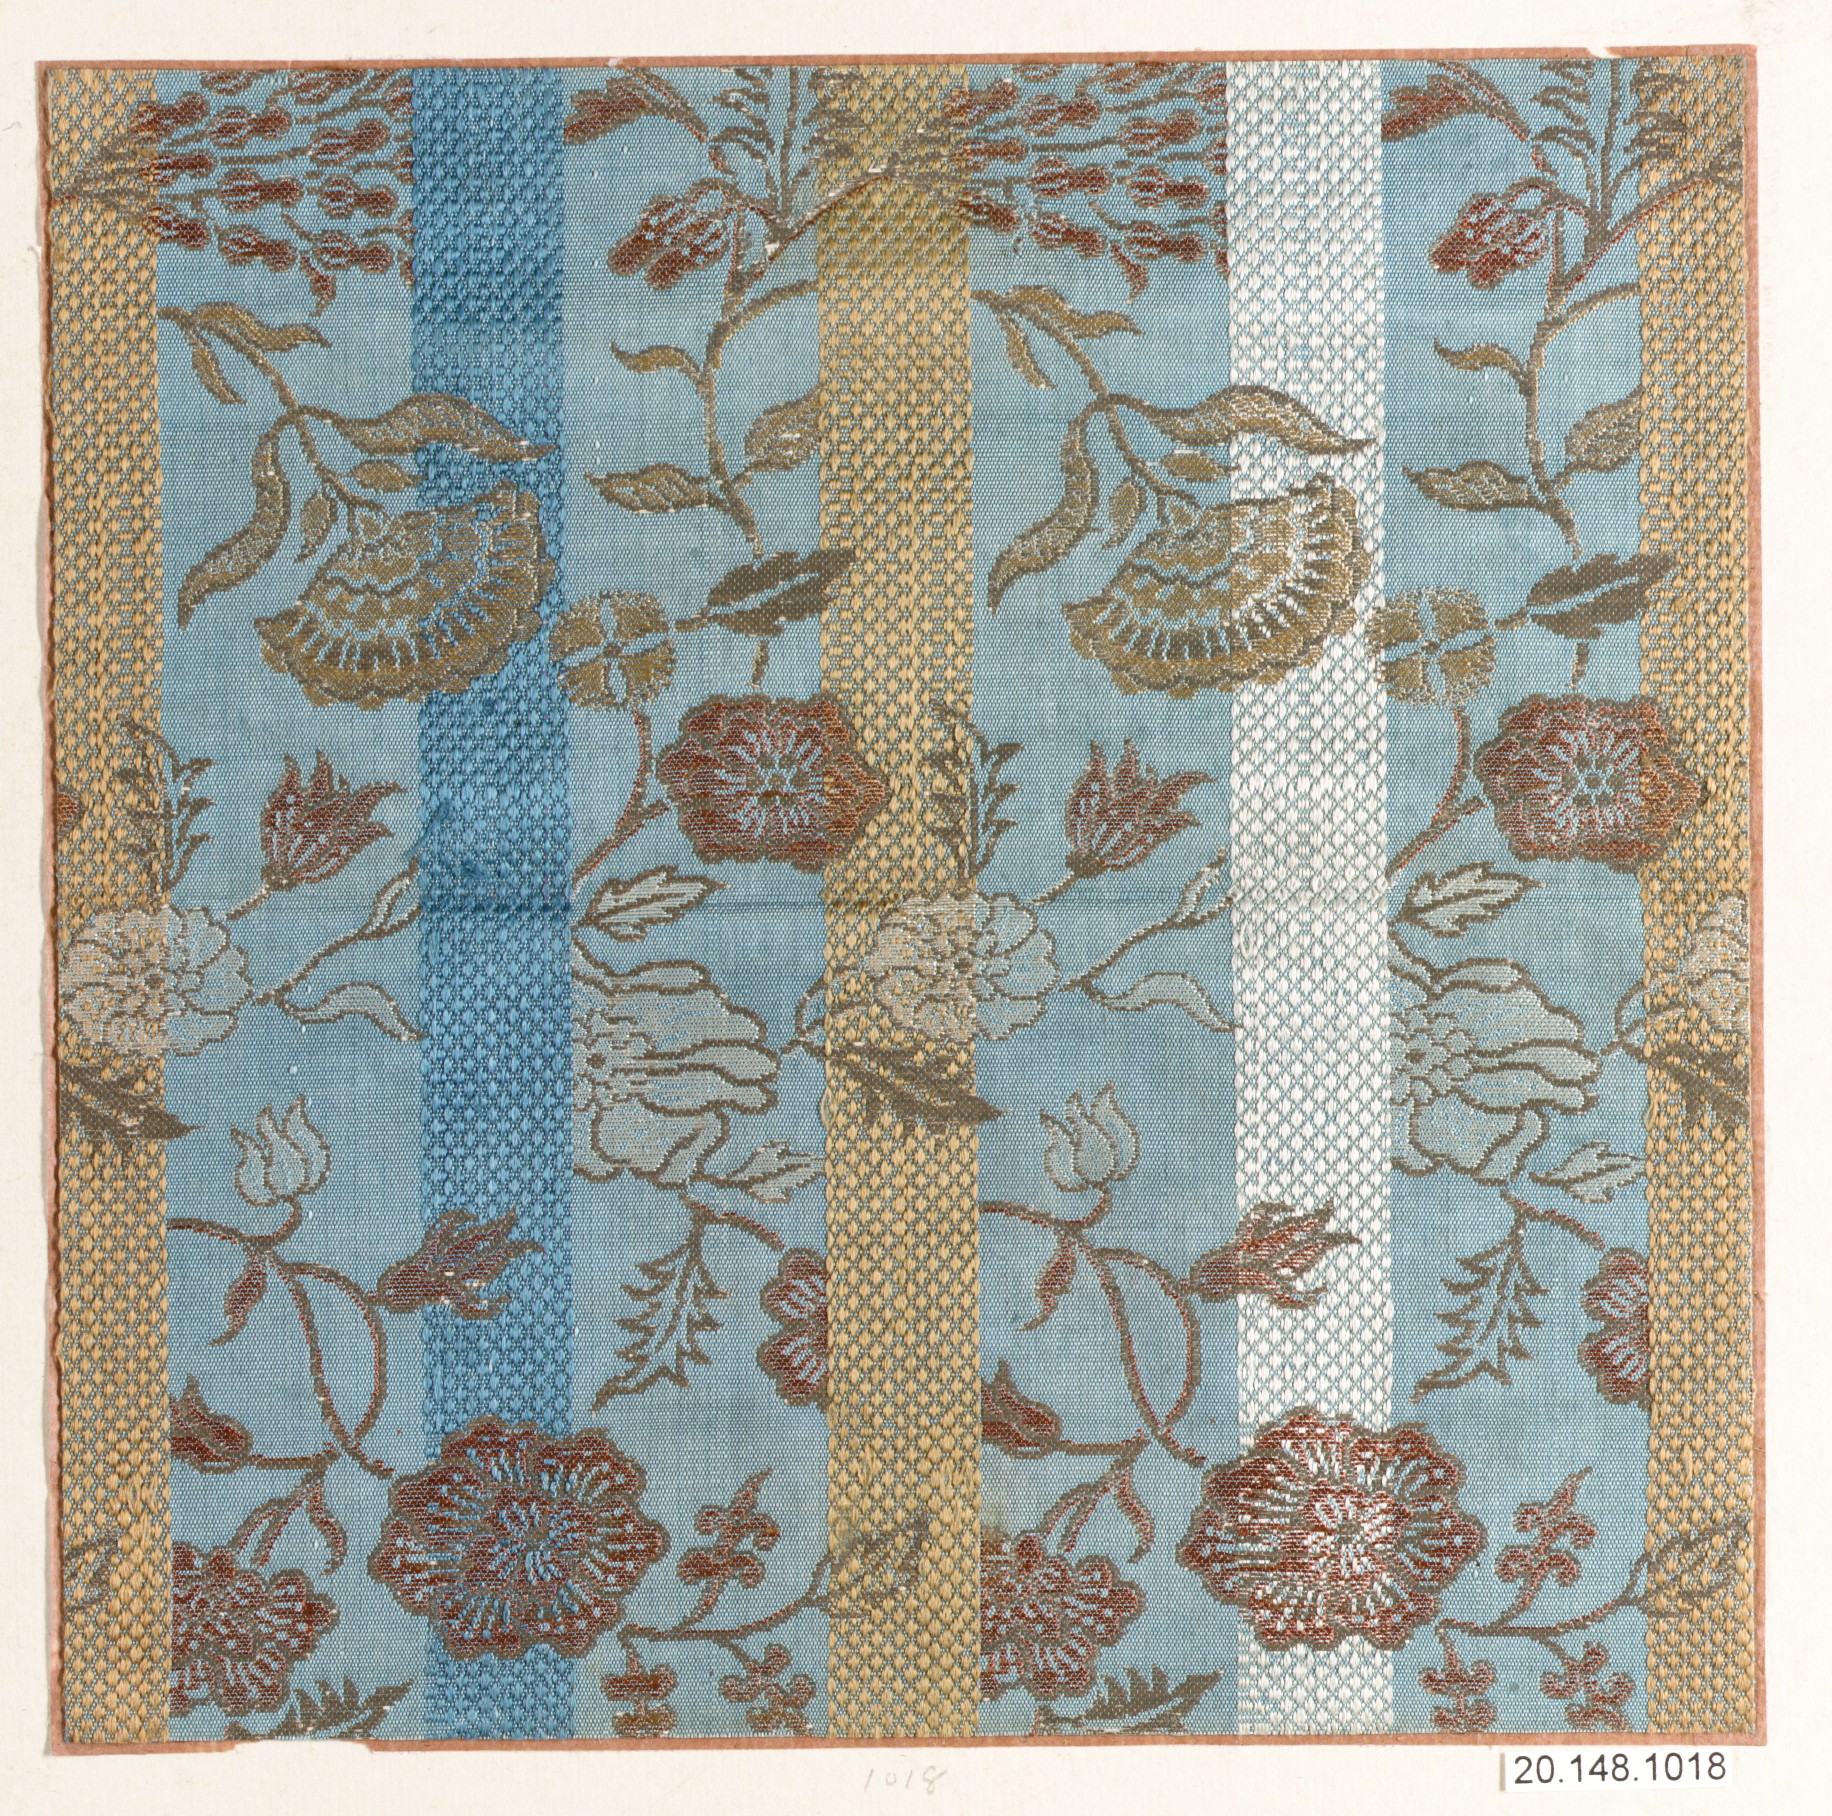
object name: piece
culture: chinese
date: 1701-1800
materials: silk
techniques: compound weave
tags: flowers,leaves